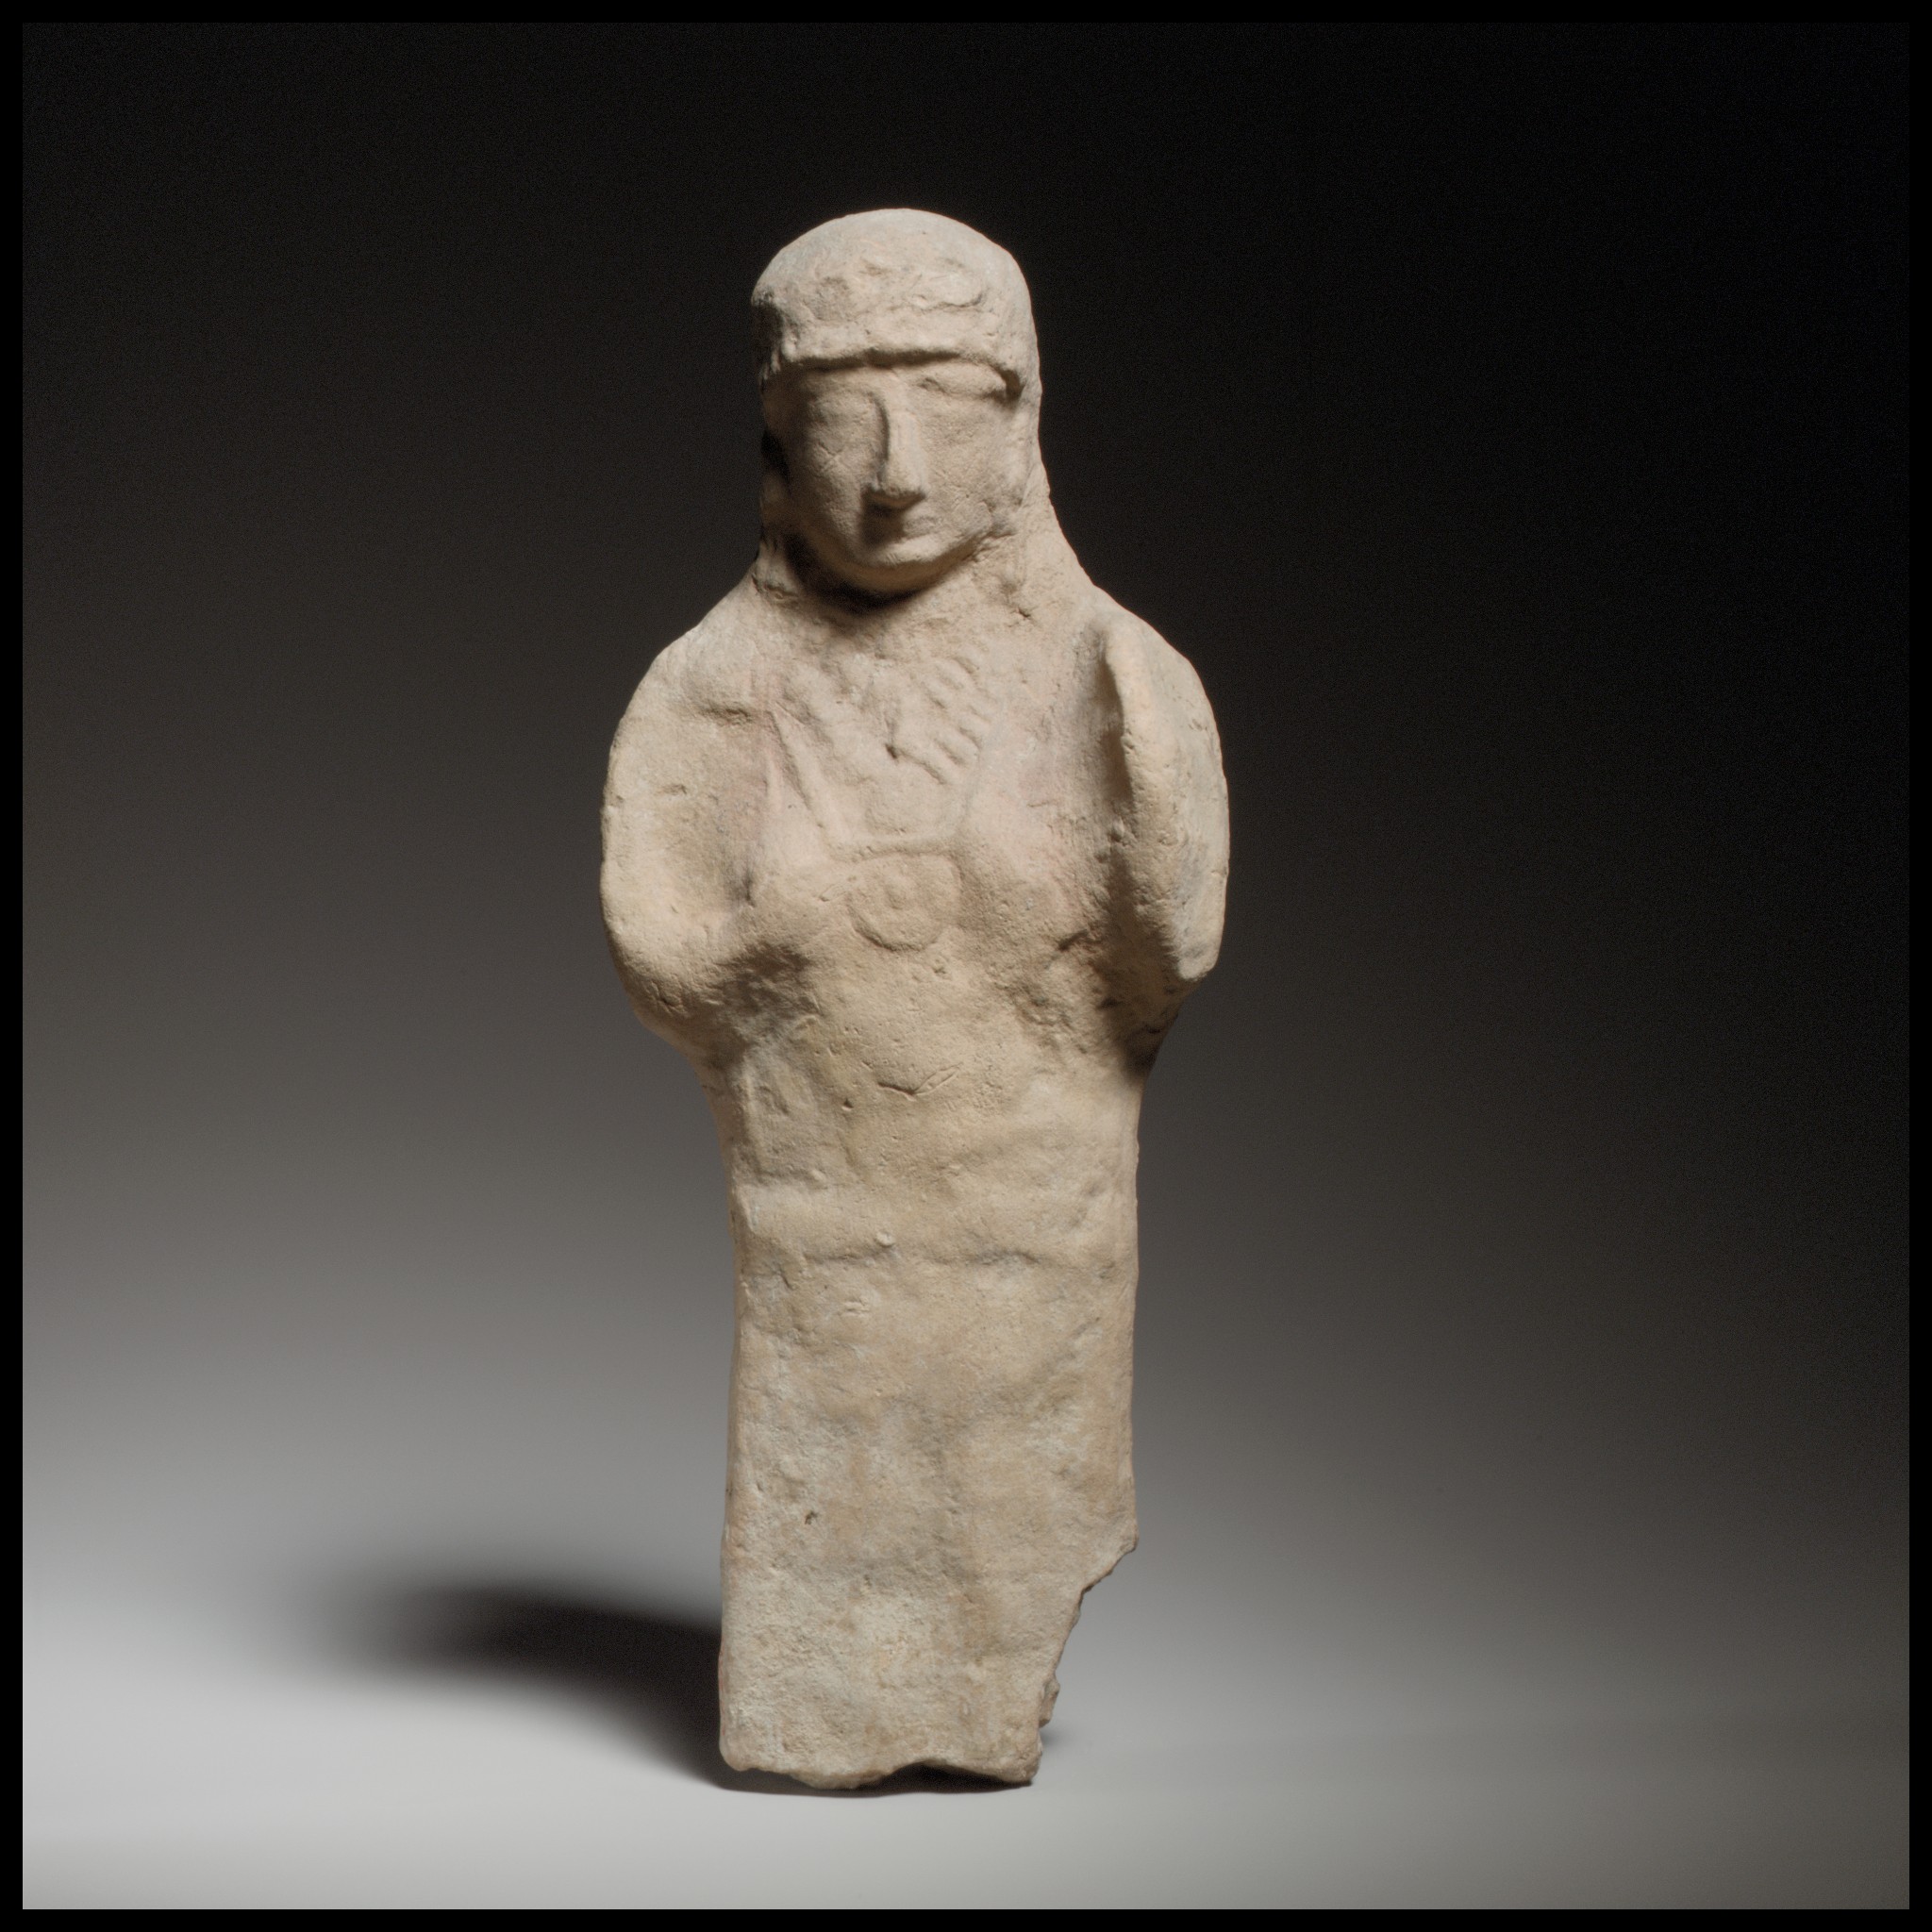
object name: statuette of a woman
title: Standing female figurine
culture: cypriot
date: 600-480 BCE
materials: terracotta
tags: women